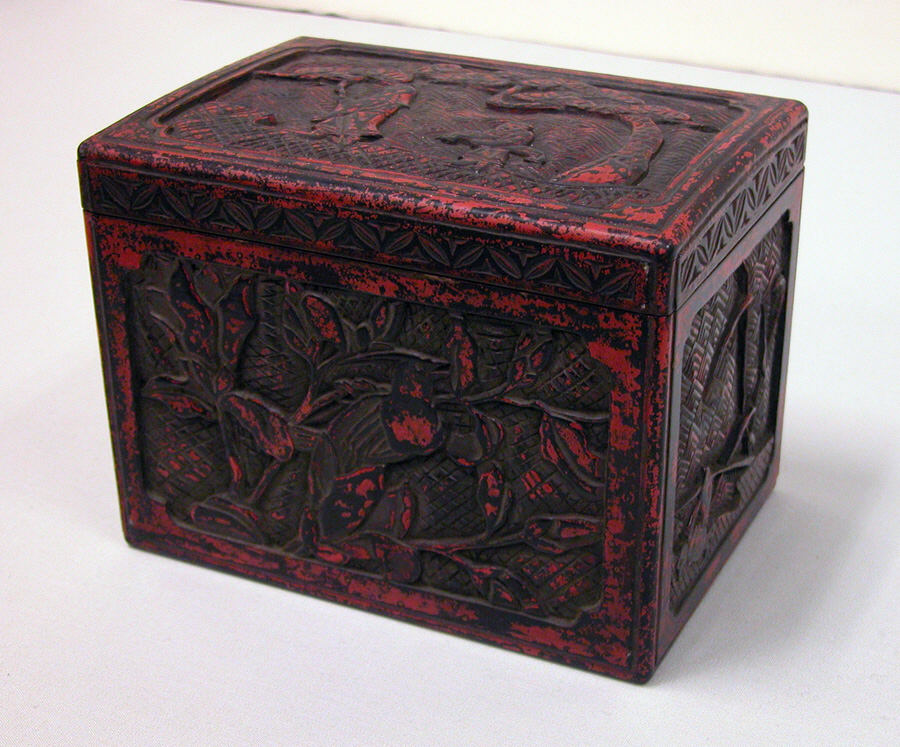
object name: box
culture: japanese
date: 1801-1833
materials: lacquer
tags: human figures,leaves